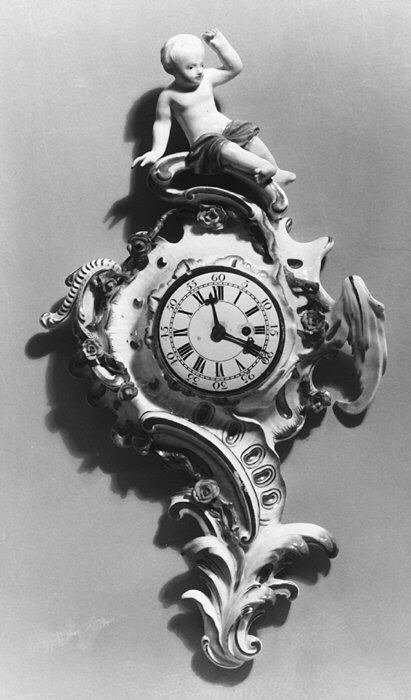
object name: wall clock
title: Wall clock (cartel)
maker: höchst manufactory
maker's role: manufactory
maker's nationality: german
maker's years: 1746-1796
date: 1765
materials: hard paste porcelain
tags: putti